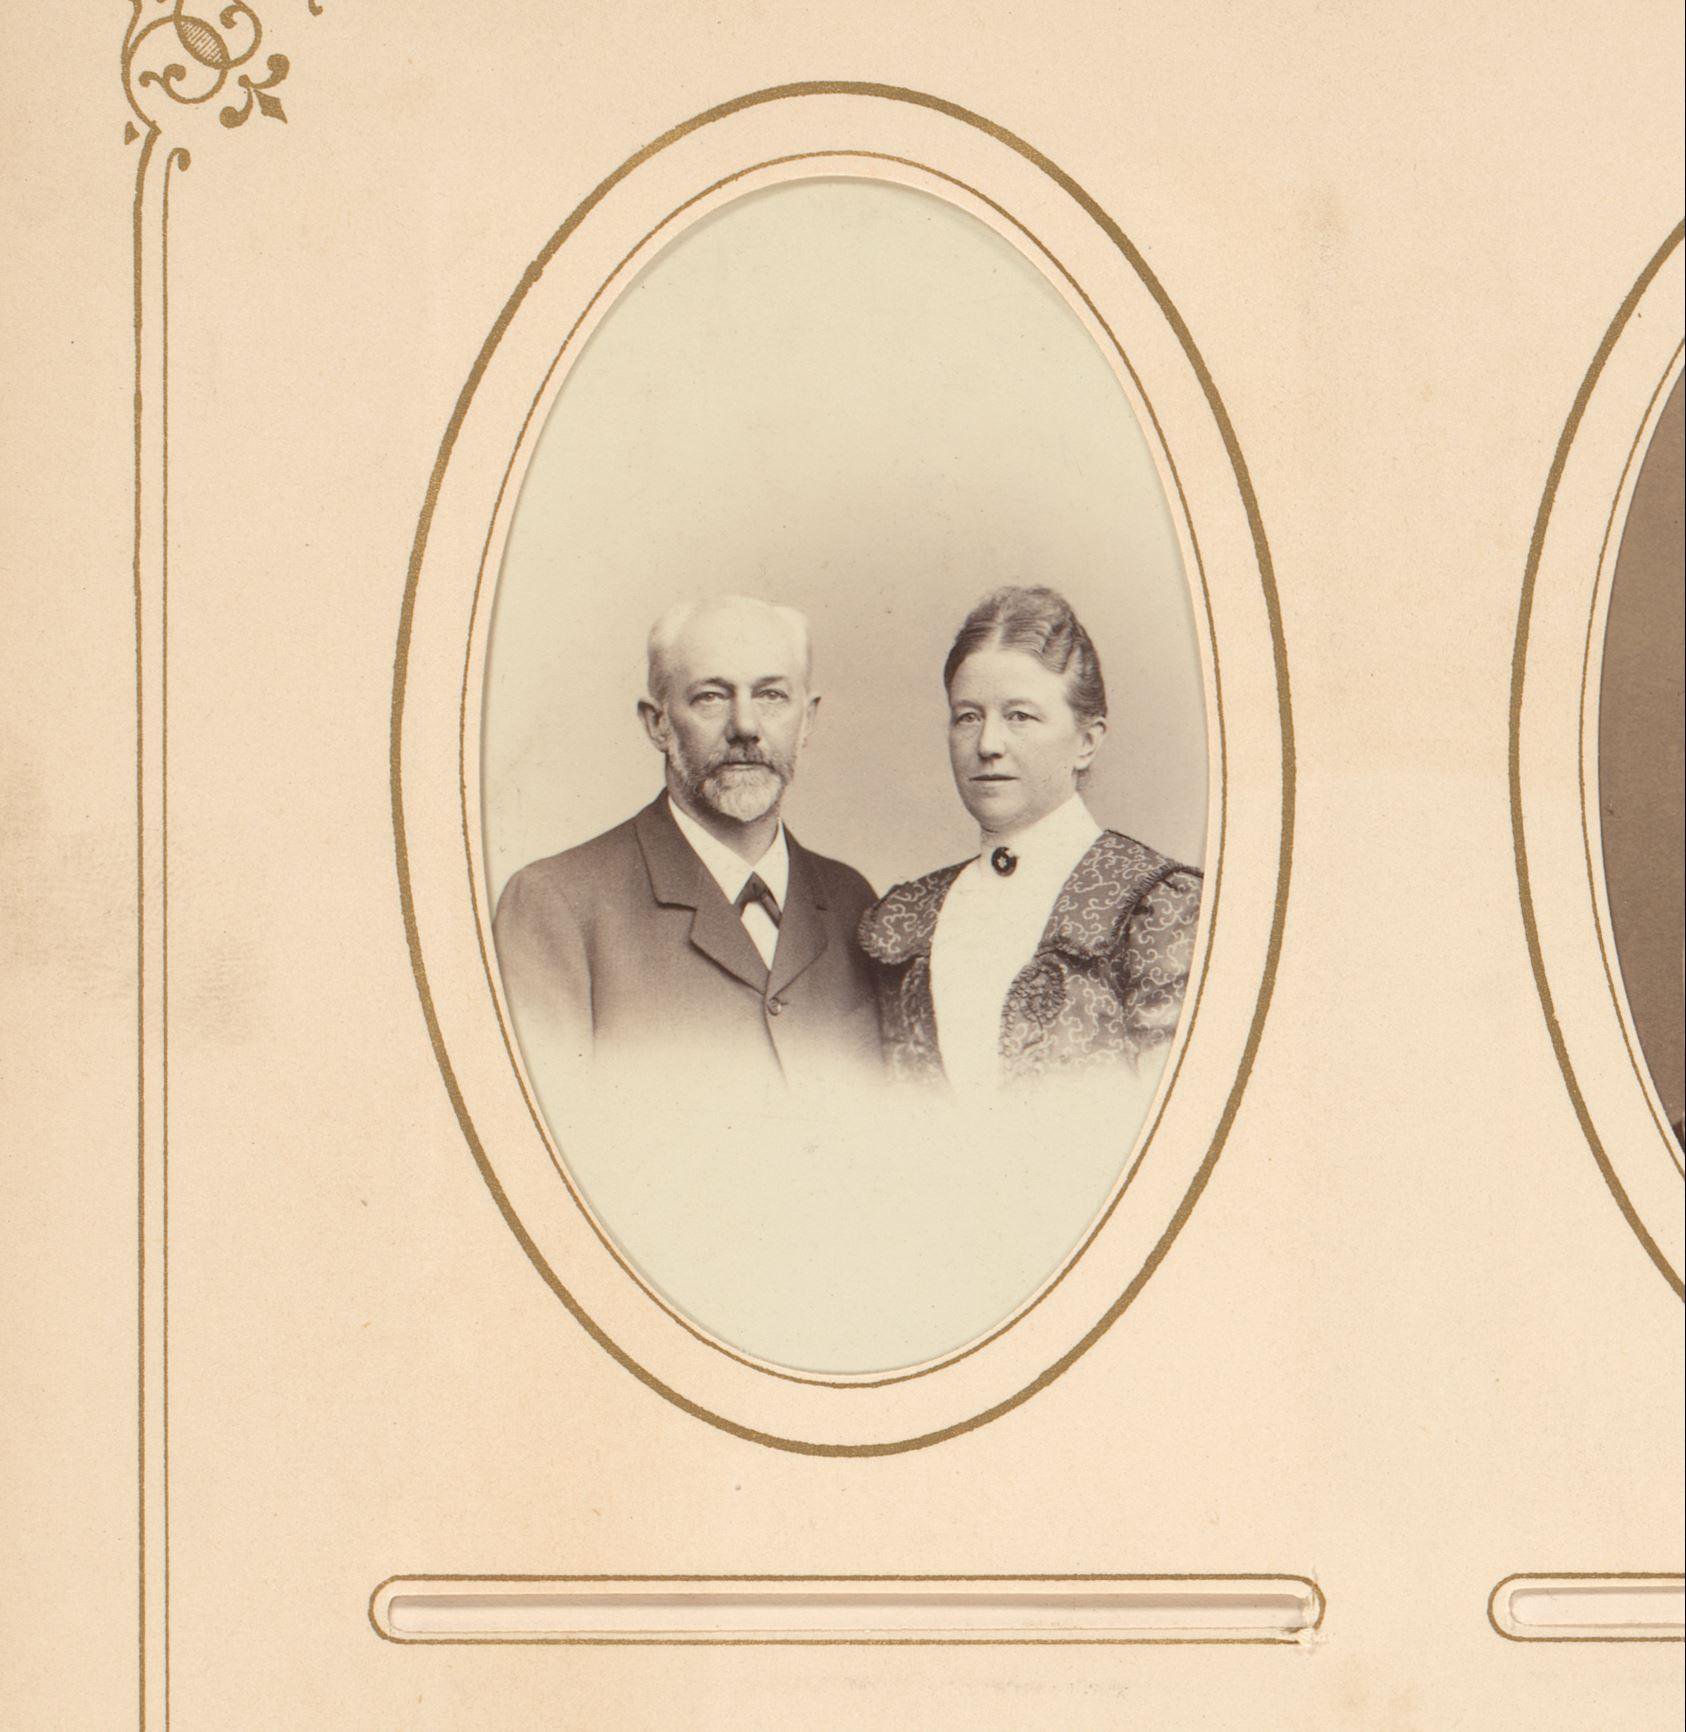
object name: carte de visite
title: Portret van een man en een vrouw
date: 1880-1890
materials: cardboard, photographic support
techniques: albumen print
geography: hamburg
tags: historical persons - bb - woman, historical persons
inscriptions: annotation: ‘Johan Berckling/ & Marie/ geb. Sch[ät]ze’, inscription: ‘Benque & Kindermann/ Hofphotographen/ Hamburg, Esplanade 2./ (...)’